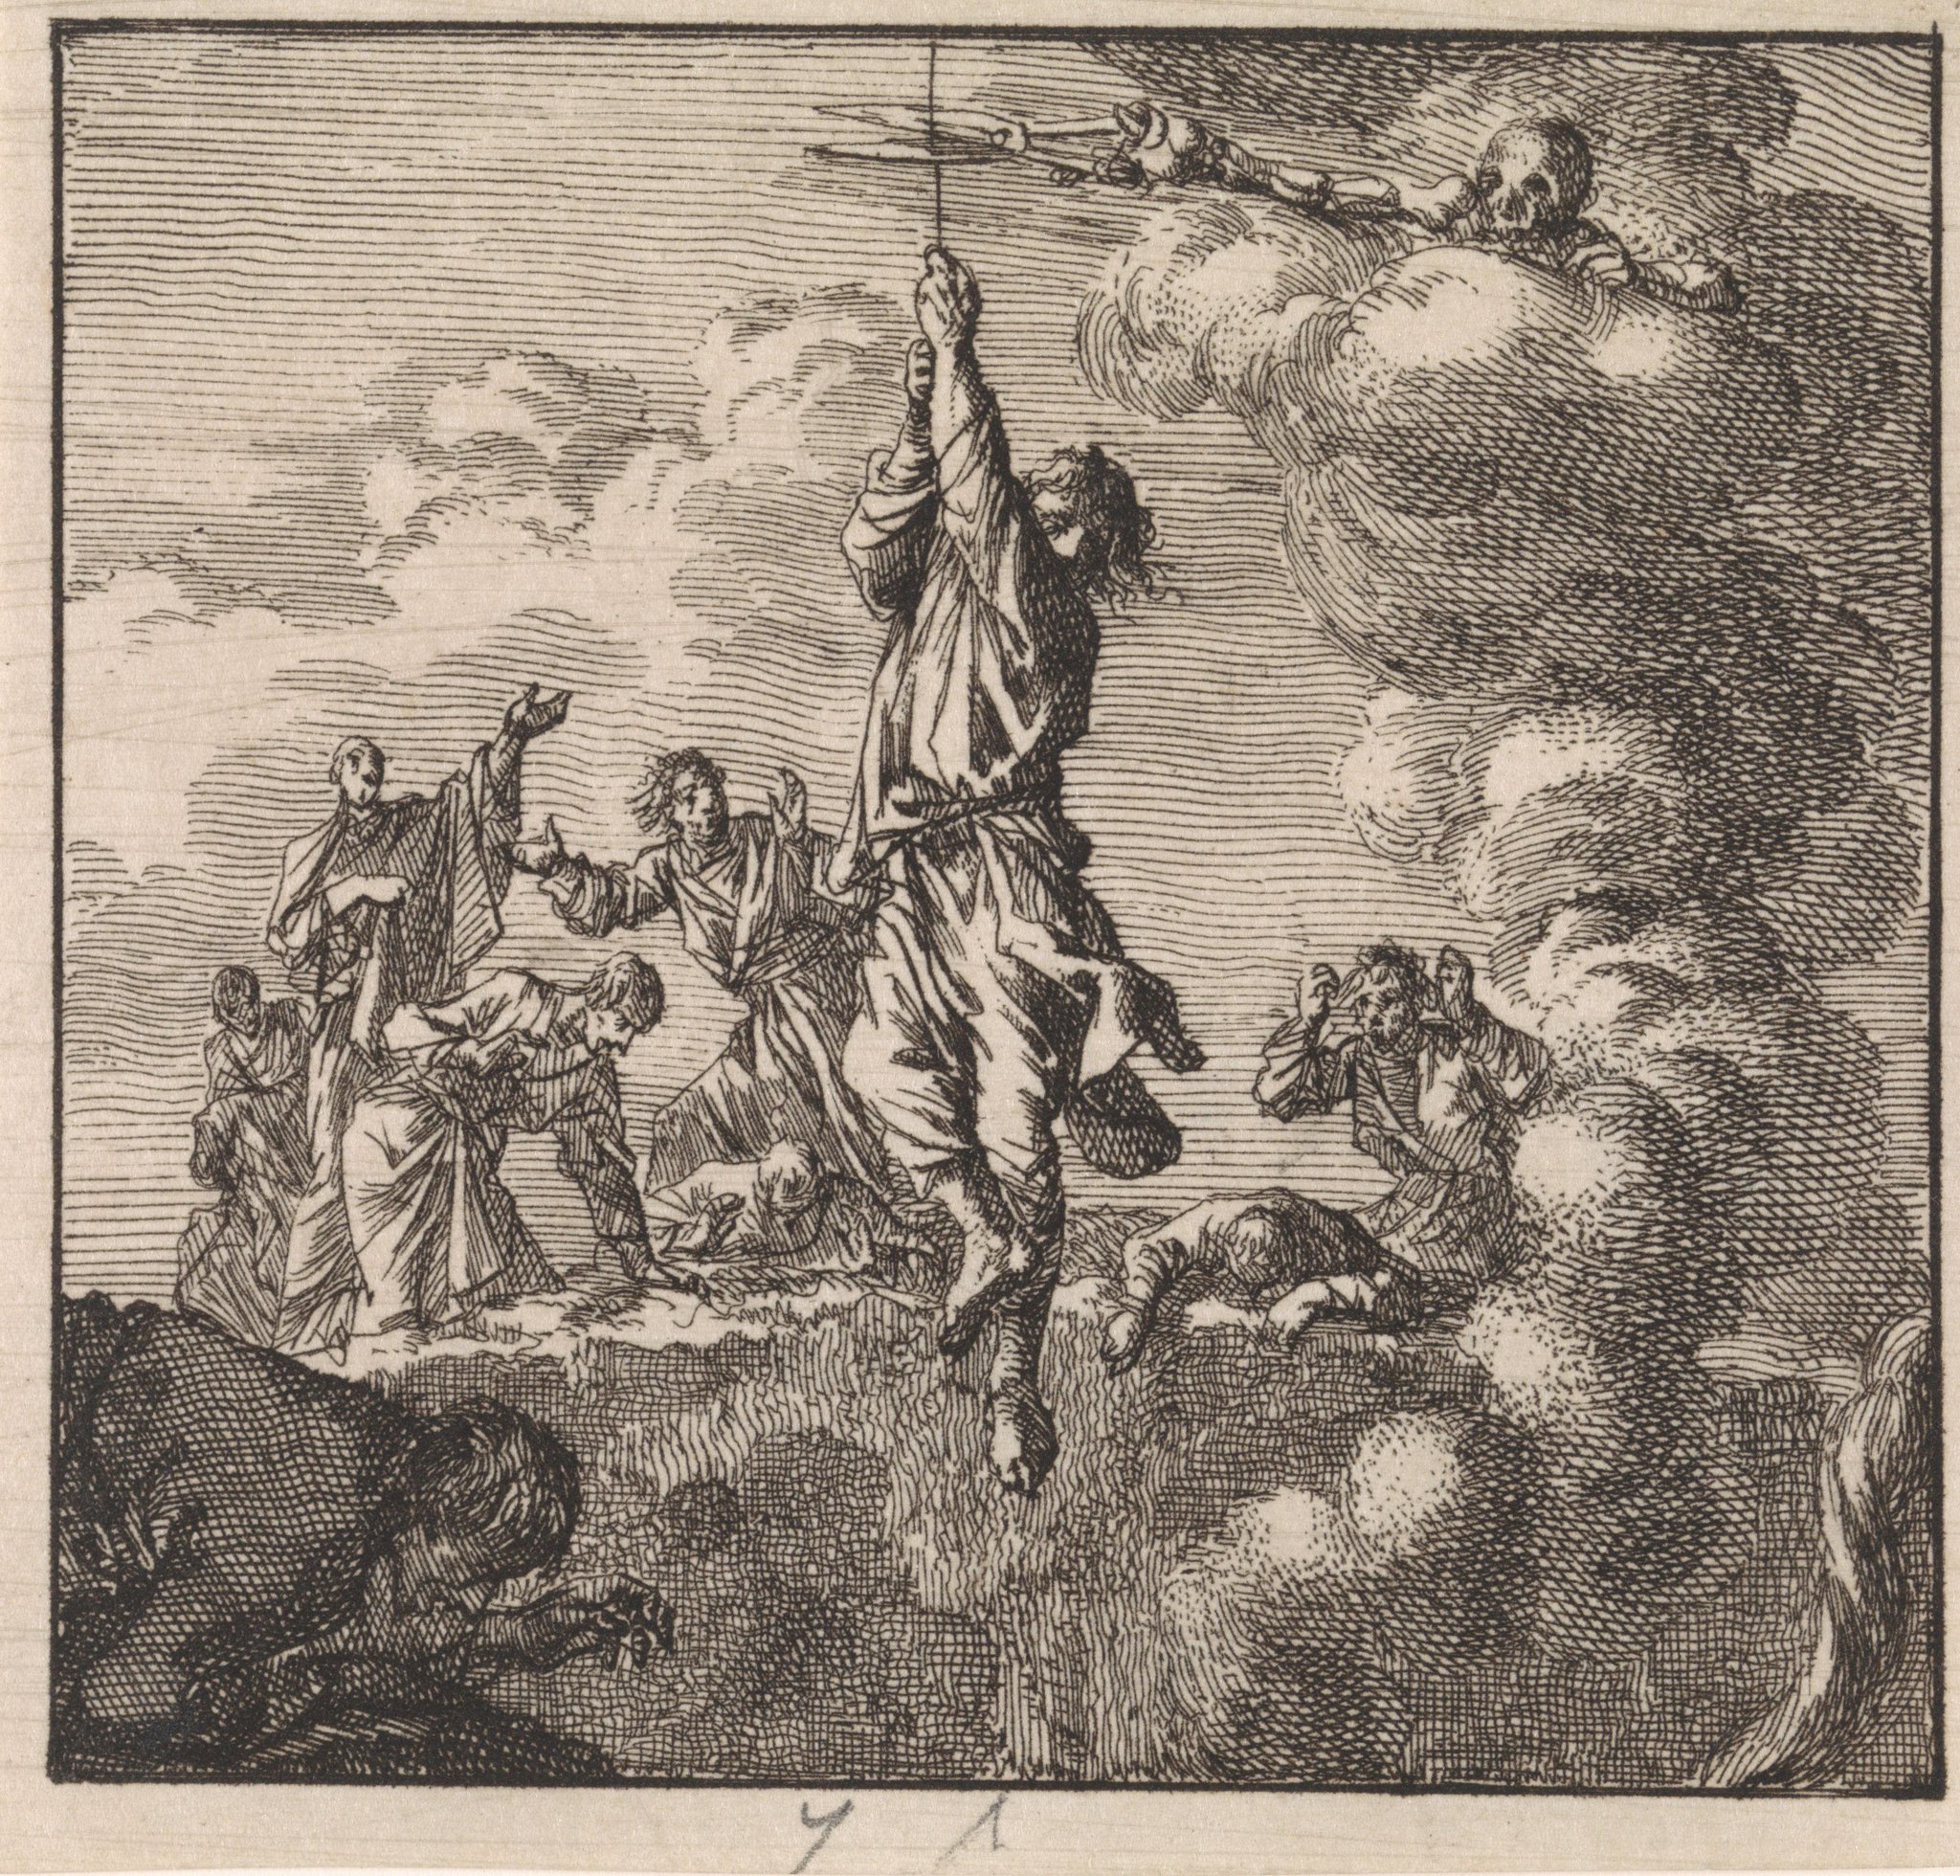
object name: print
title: De gevaarlyke Stand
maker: jan luyken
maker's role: draughtsman, print maker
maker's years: 1649-1712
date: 1710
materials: paper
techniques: etching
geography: amsterdam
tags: volcano, tools, aids, implements ~ crafts and industries: scissors, death as skeleton - ff - death as female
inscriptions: collector's mark: Lugt 2228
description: Proefdruk voor illustratie uit: Luyken, Jan. De onwaardige wereld, vertoond in vyftig zinnebeelden, met godlyke spreuken en stichtelyke verzen. Amsterdam: Pieter Arentsz. II (wed.) en Cornelis van der Sys, 1710, p. 26.